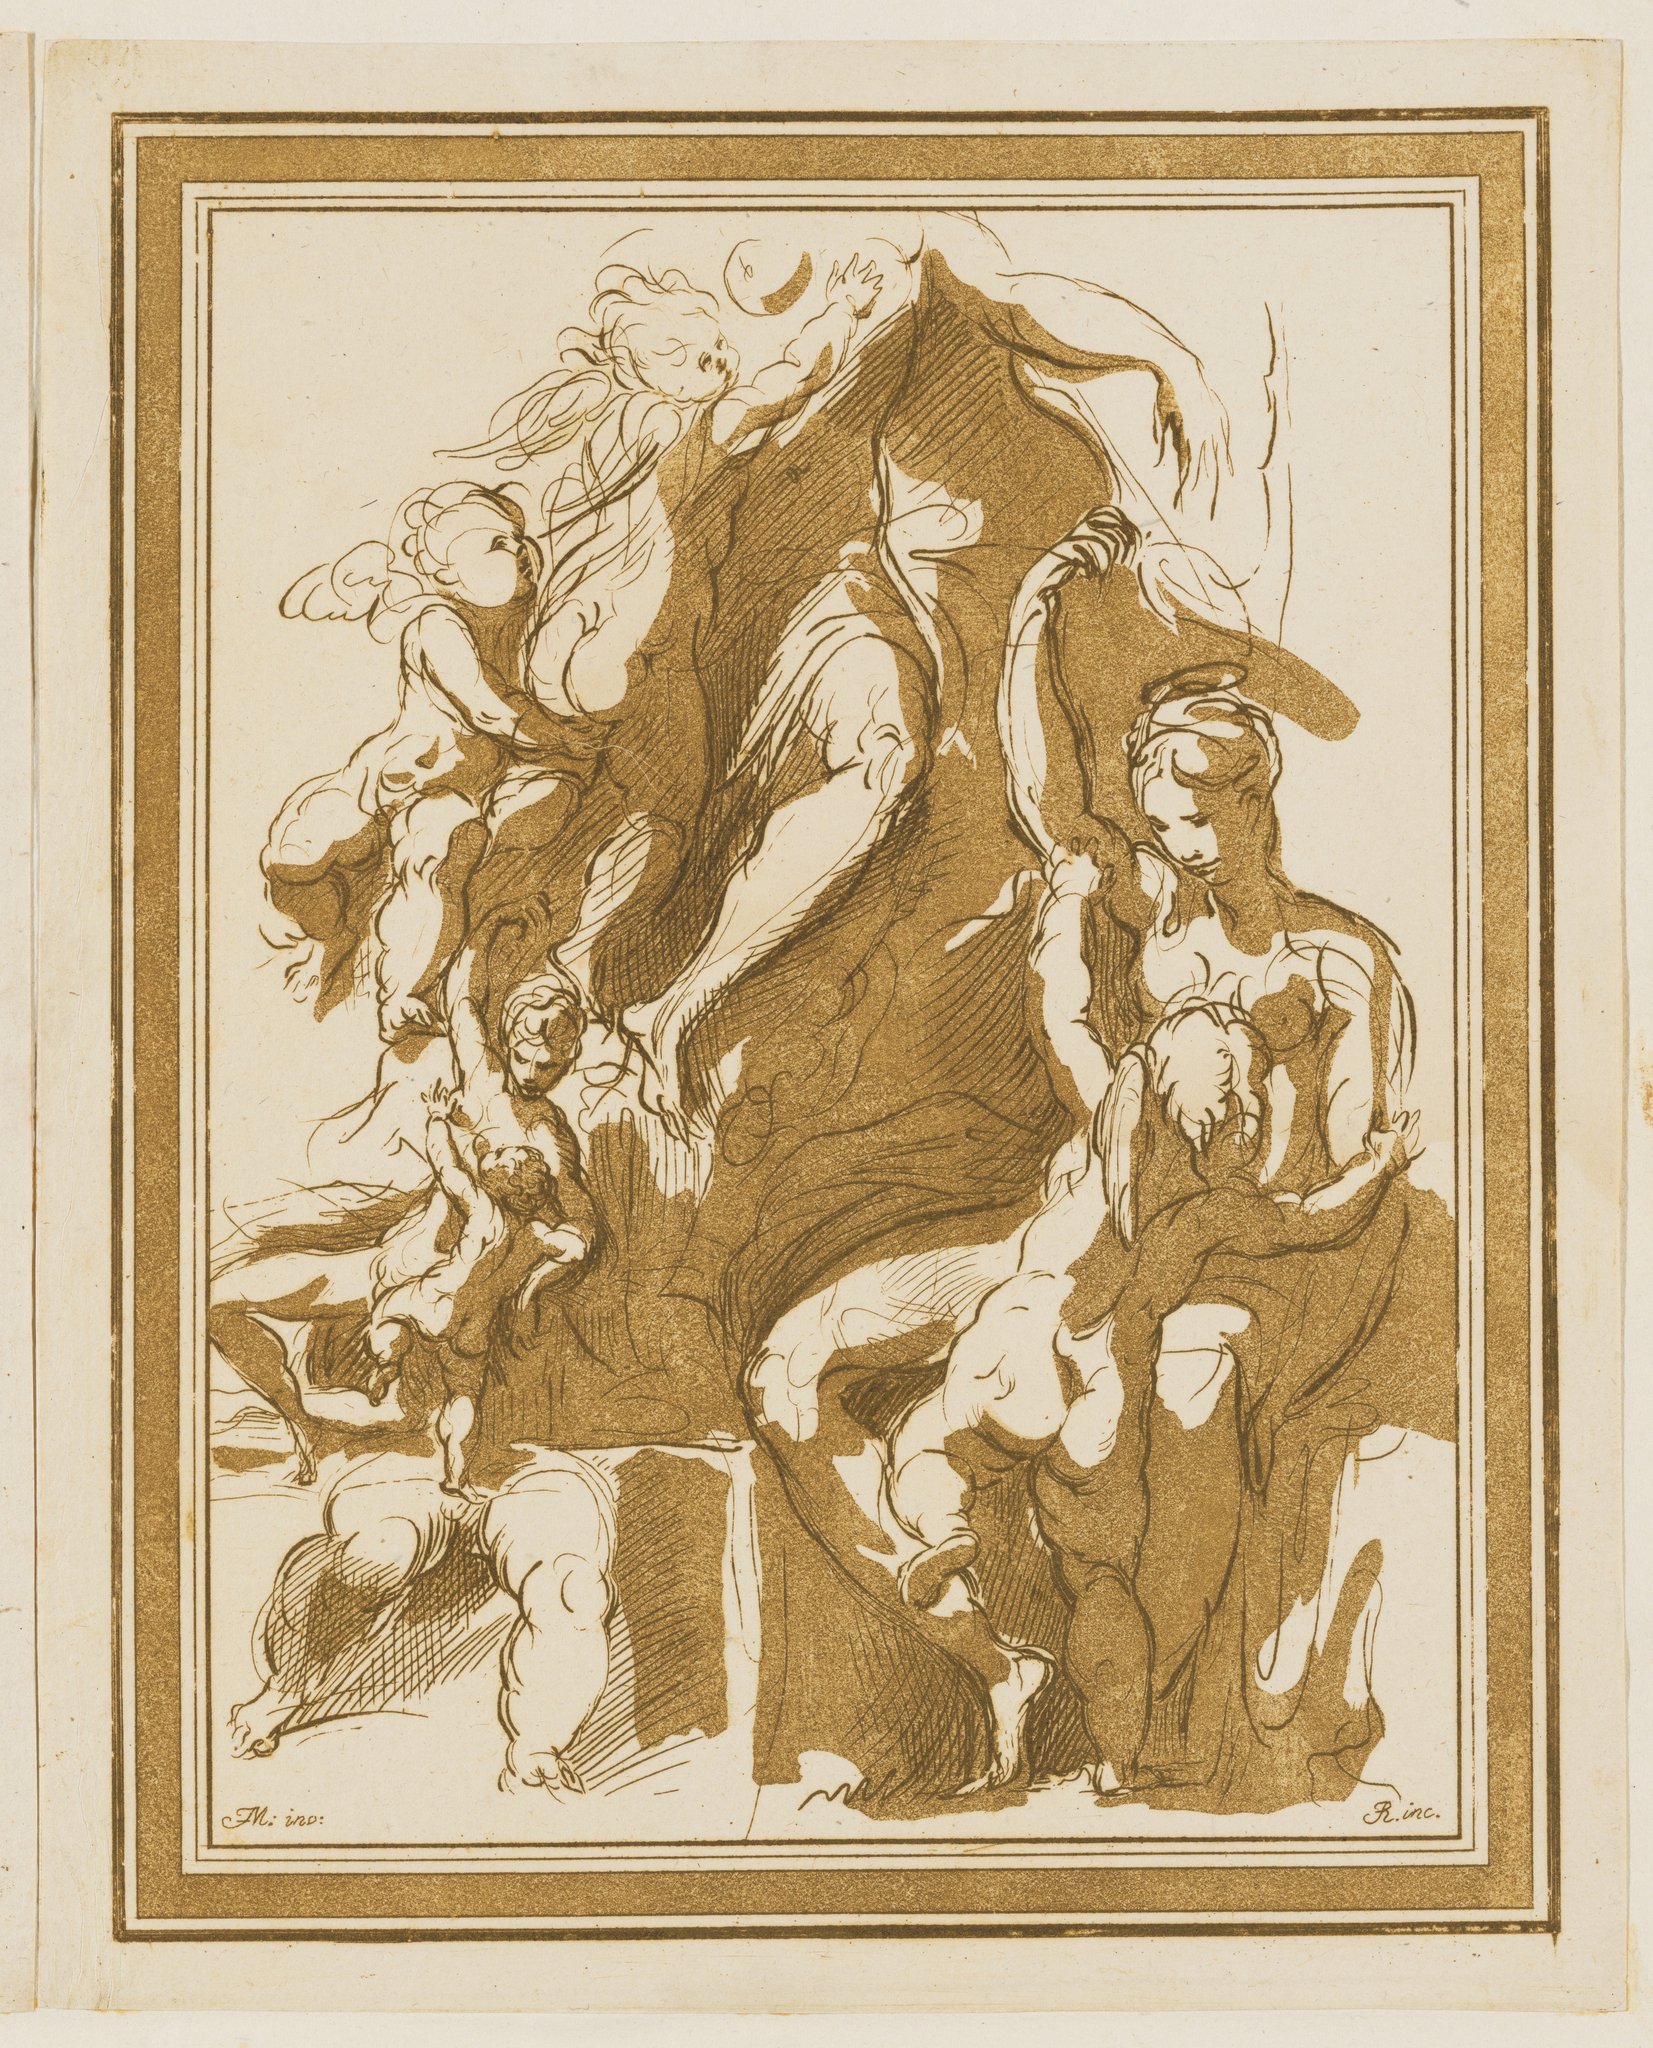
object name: print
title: Study of Venus and Cupid, from Prove di Vari Rami Inediti [...]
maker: francesco rosaspina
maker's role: artist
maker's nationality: italian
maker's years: 1762-1841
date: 1801-1900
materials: ink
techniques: aquatint, etching